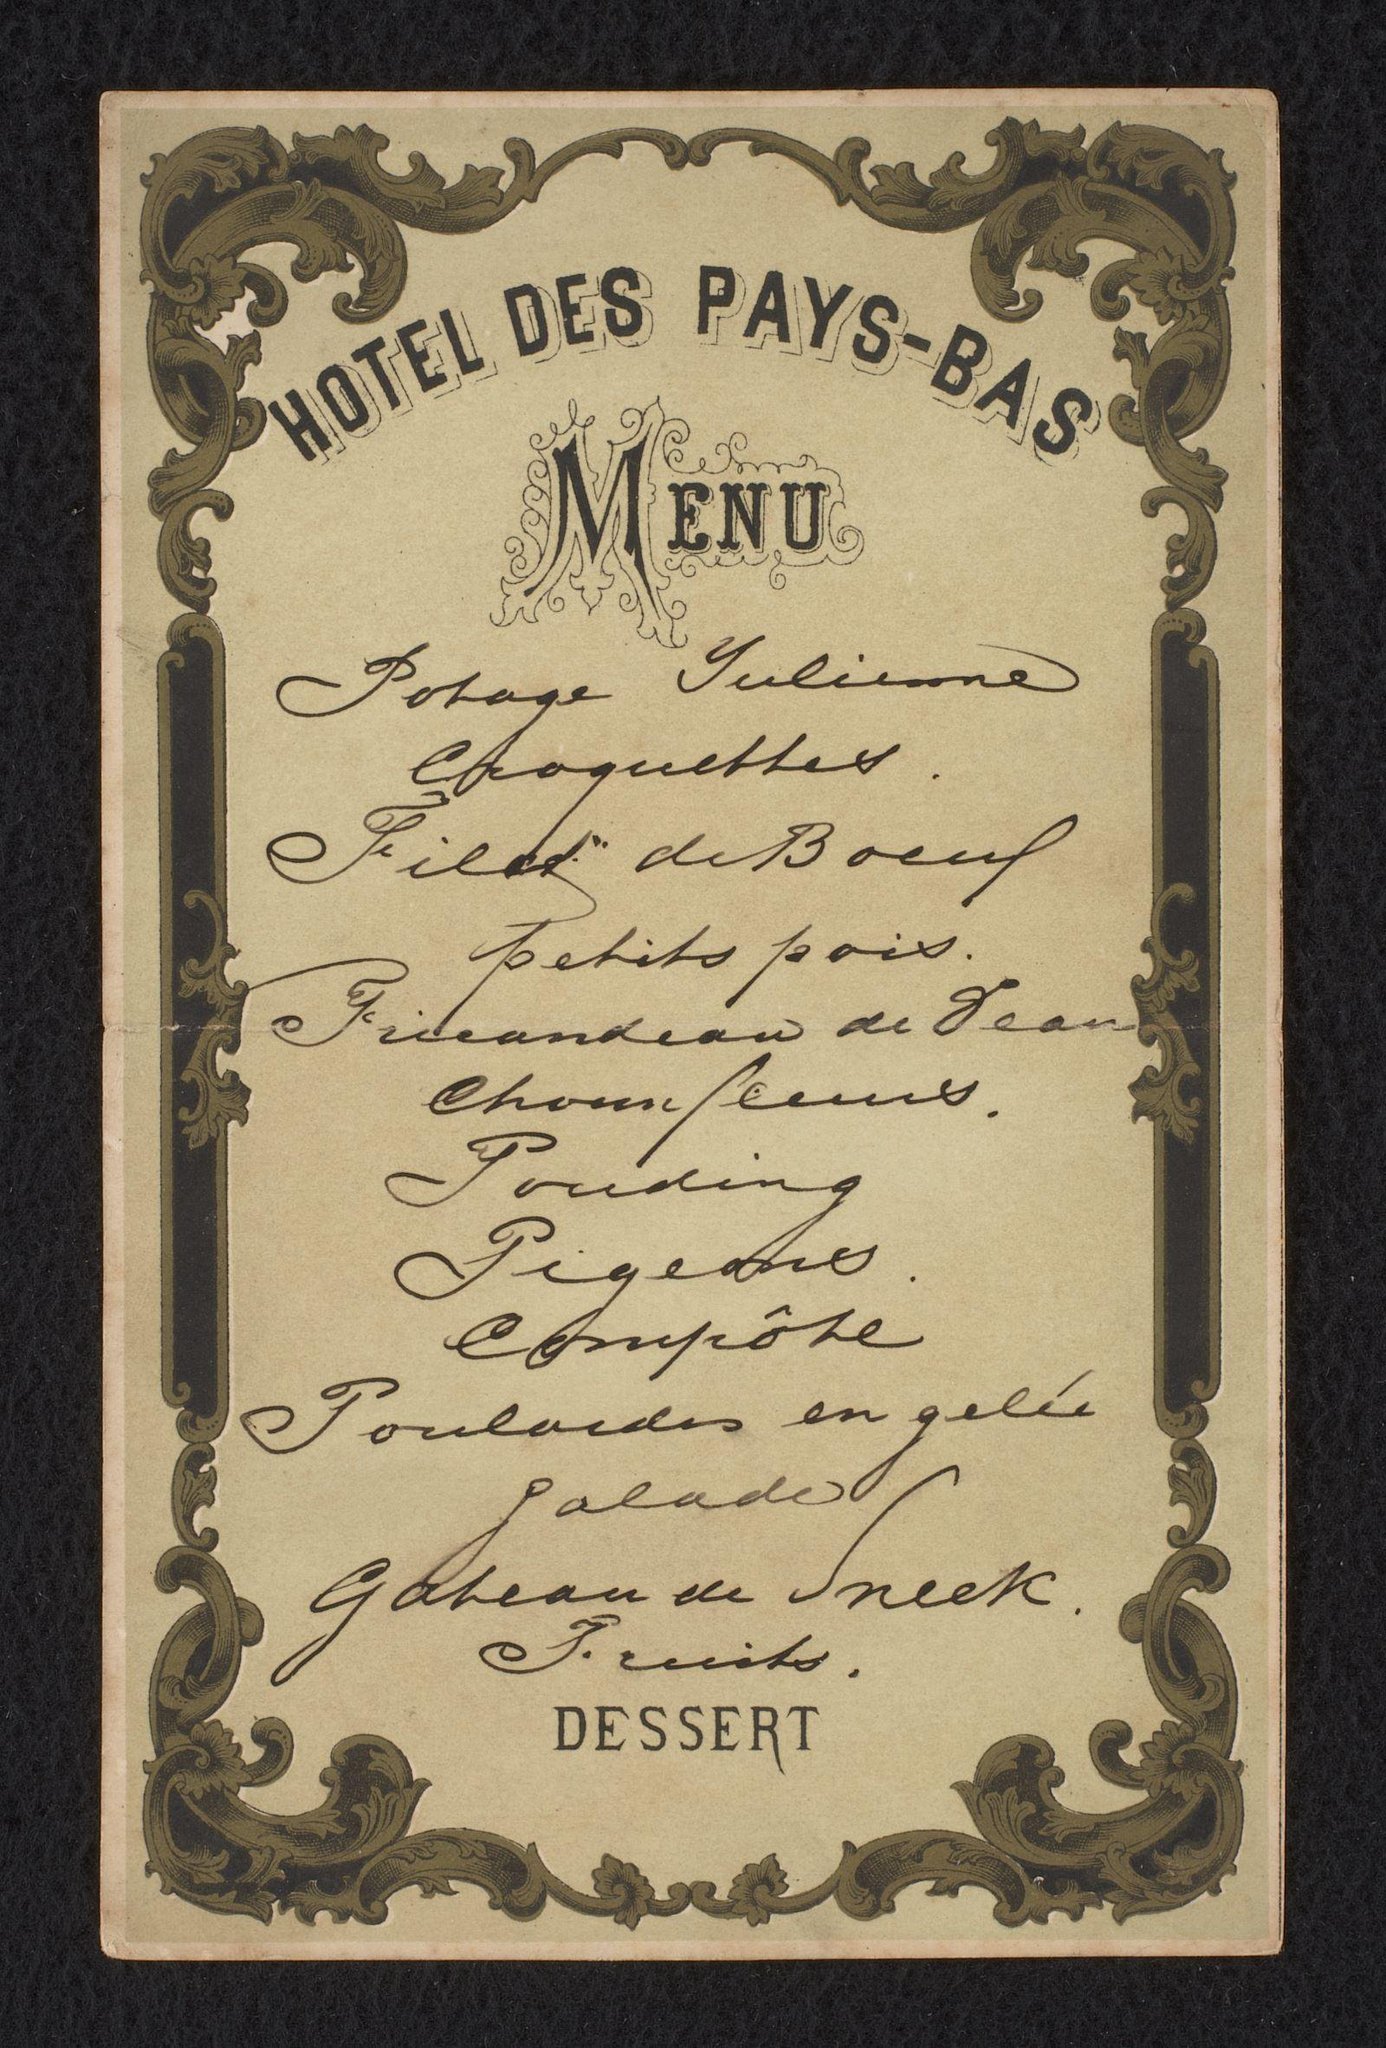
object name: menu, menukaart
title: Menukaart voor Hotel des Pays-Bas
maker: Anonymous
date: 1850-1900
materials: paper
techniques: pen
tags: 43b311(+12)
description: Bij gebrek aan gegevens over de vervaardiger is voor de bepaling van de rechten van dit object gebruik gemaakt van de (geschatte) vervaardigingsdatum.